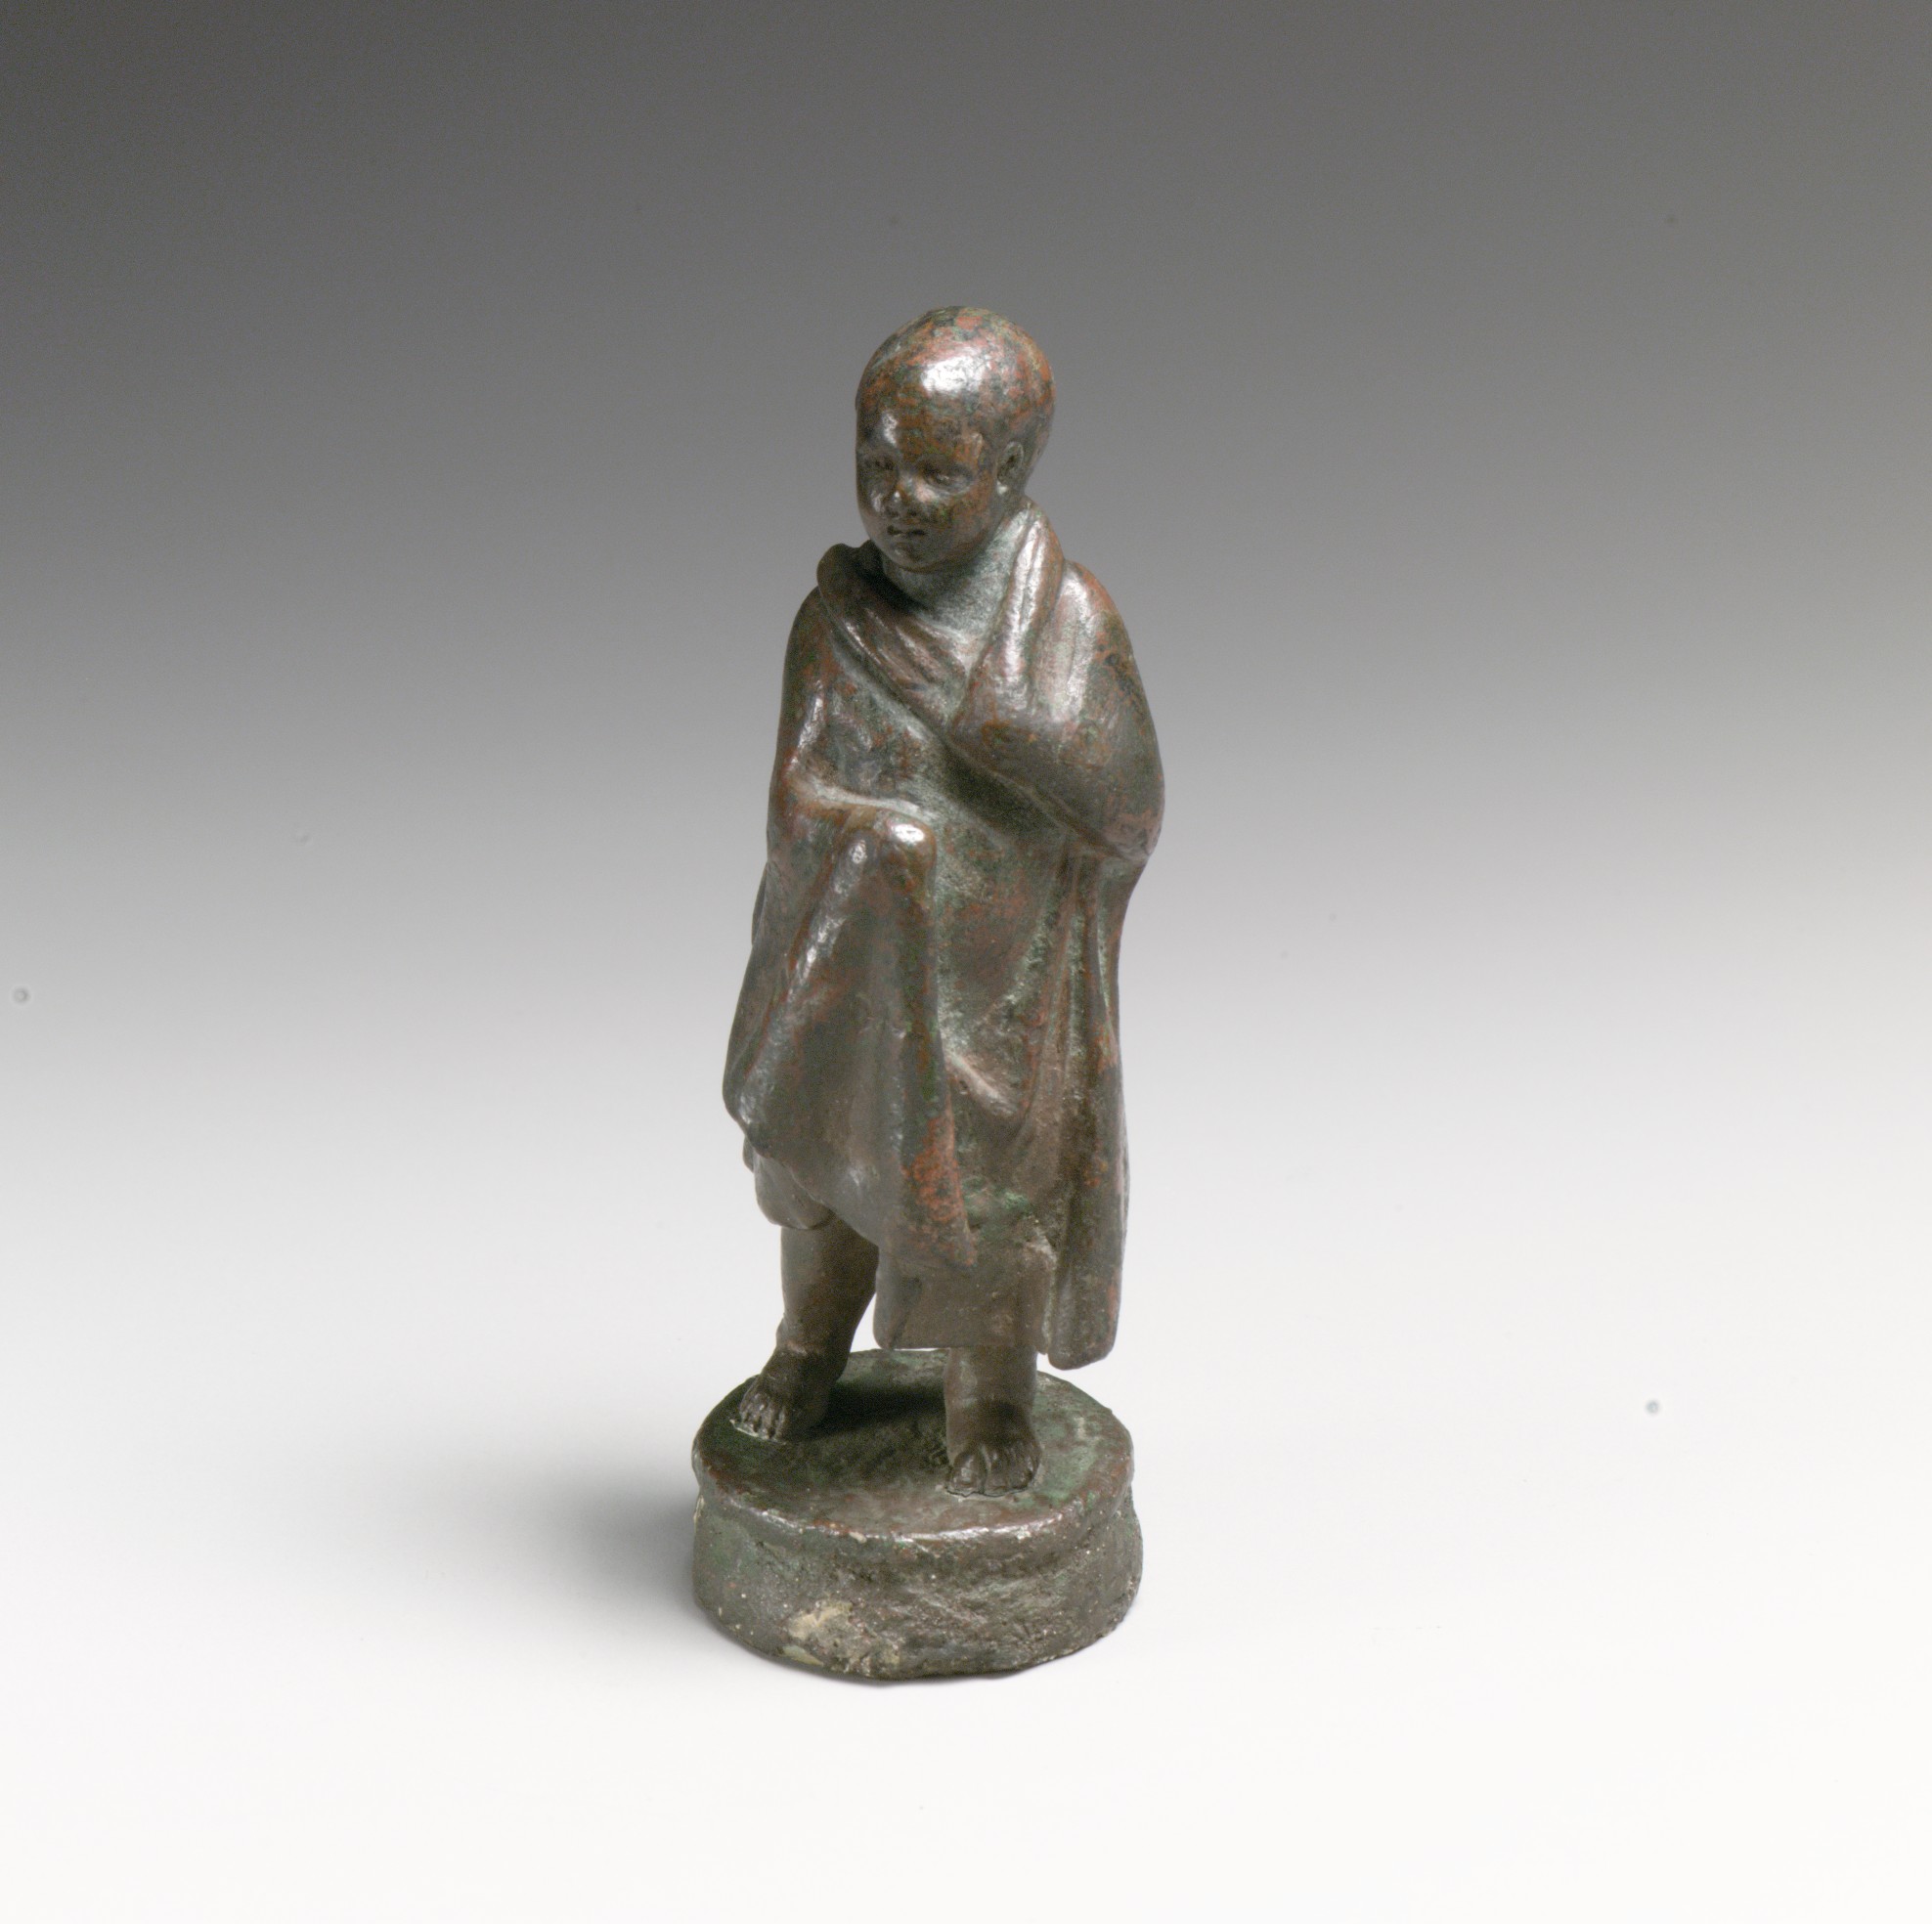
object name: statuette of a boy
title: Bronze statuette of a boy in the pose of an orator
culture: greek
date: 300-101 BCE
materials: bronze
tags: boys